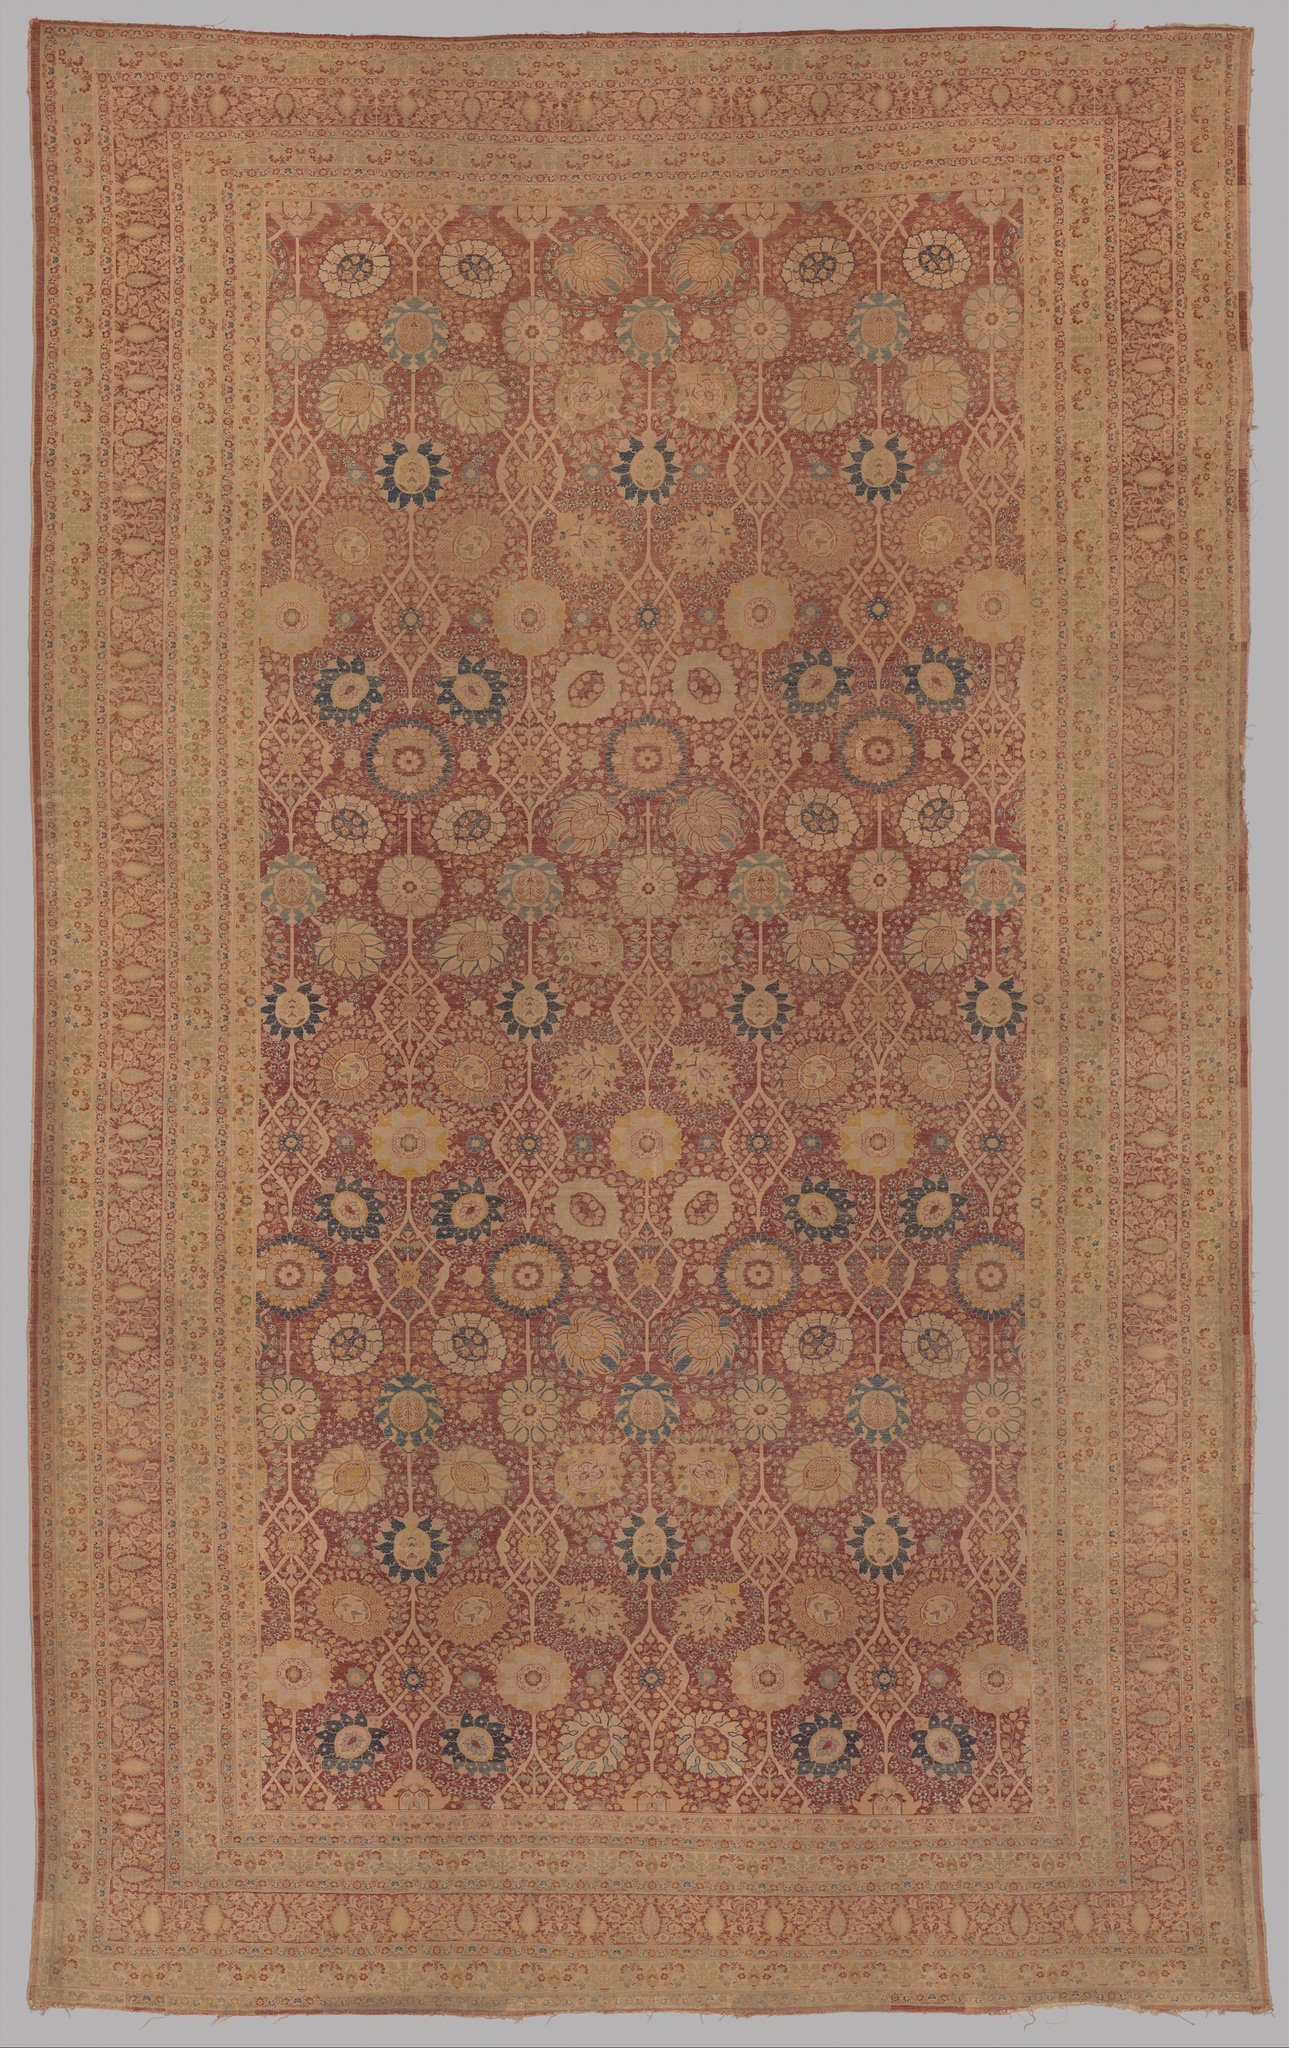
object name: carpet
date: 1701-1800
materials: silk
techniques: asymmetrically knotted pile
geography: iran